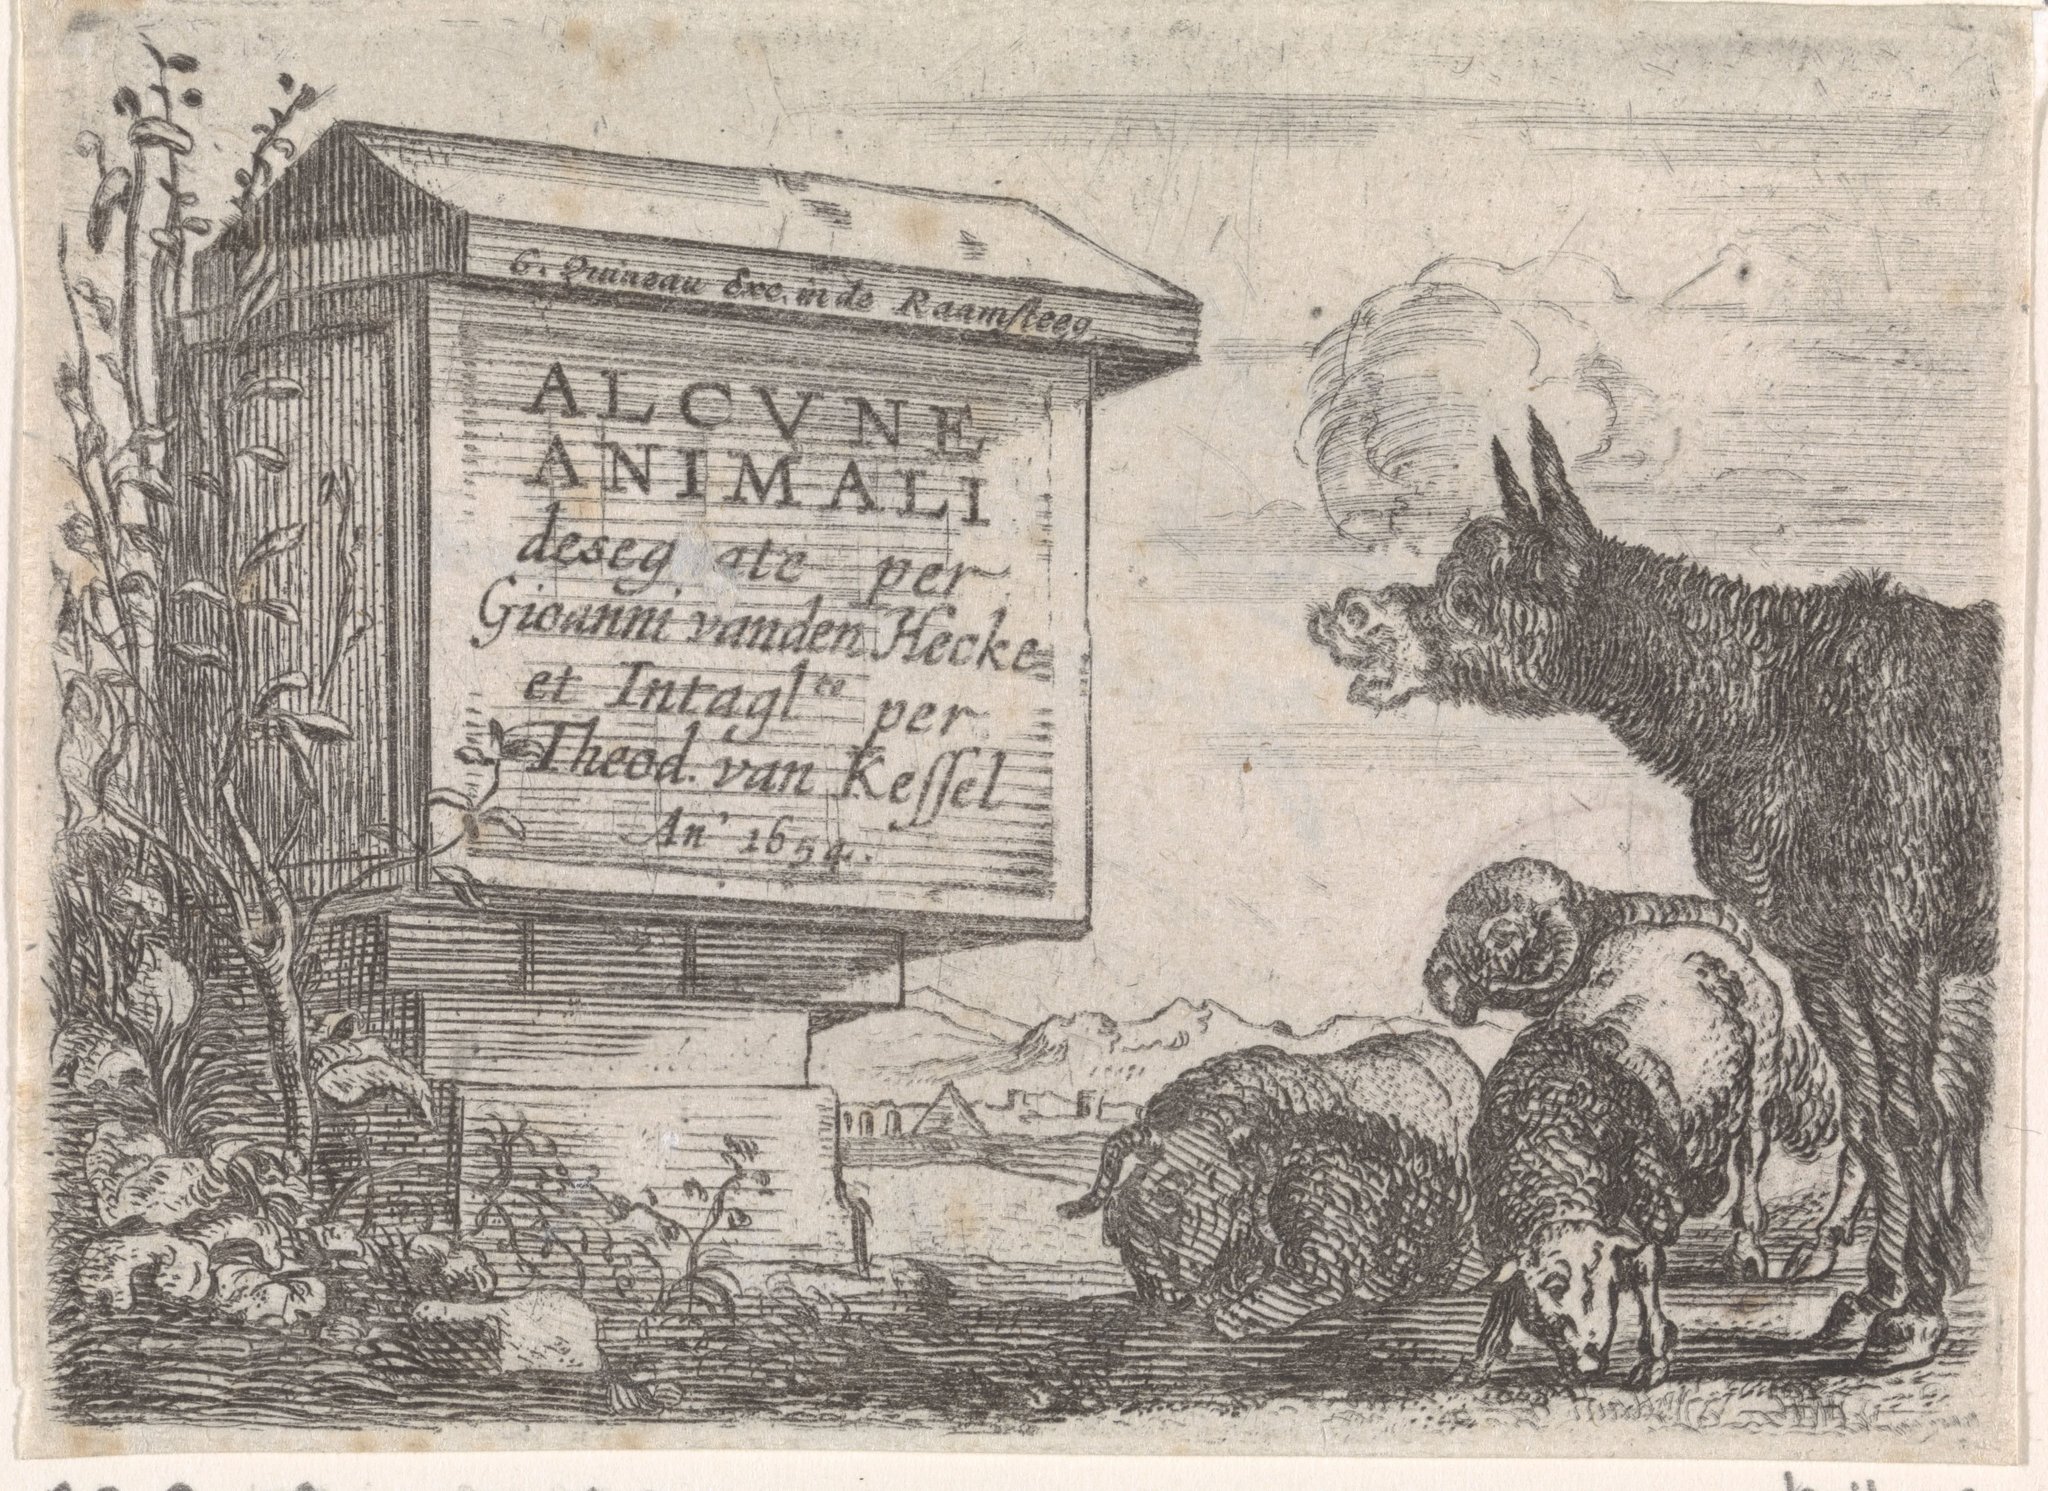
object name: print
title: Diverse dieren bij de titel van de prentenreeks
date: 1654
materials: paper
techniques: etching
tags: ass, donkey, ram, sheep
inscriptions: collector's mark: Lugt 240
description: Een balkende ezel, een schaap en twee rammen staan gezamenlijk bij een monumentale steen waarop de titel staat van de prentenreeks waar deze prent deel van uitmaakt.